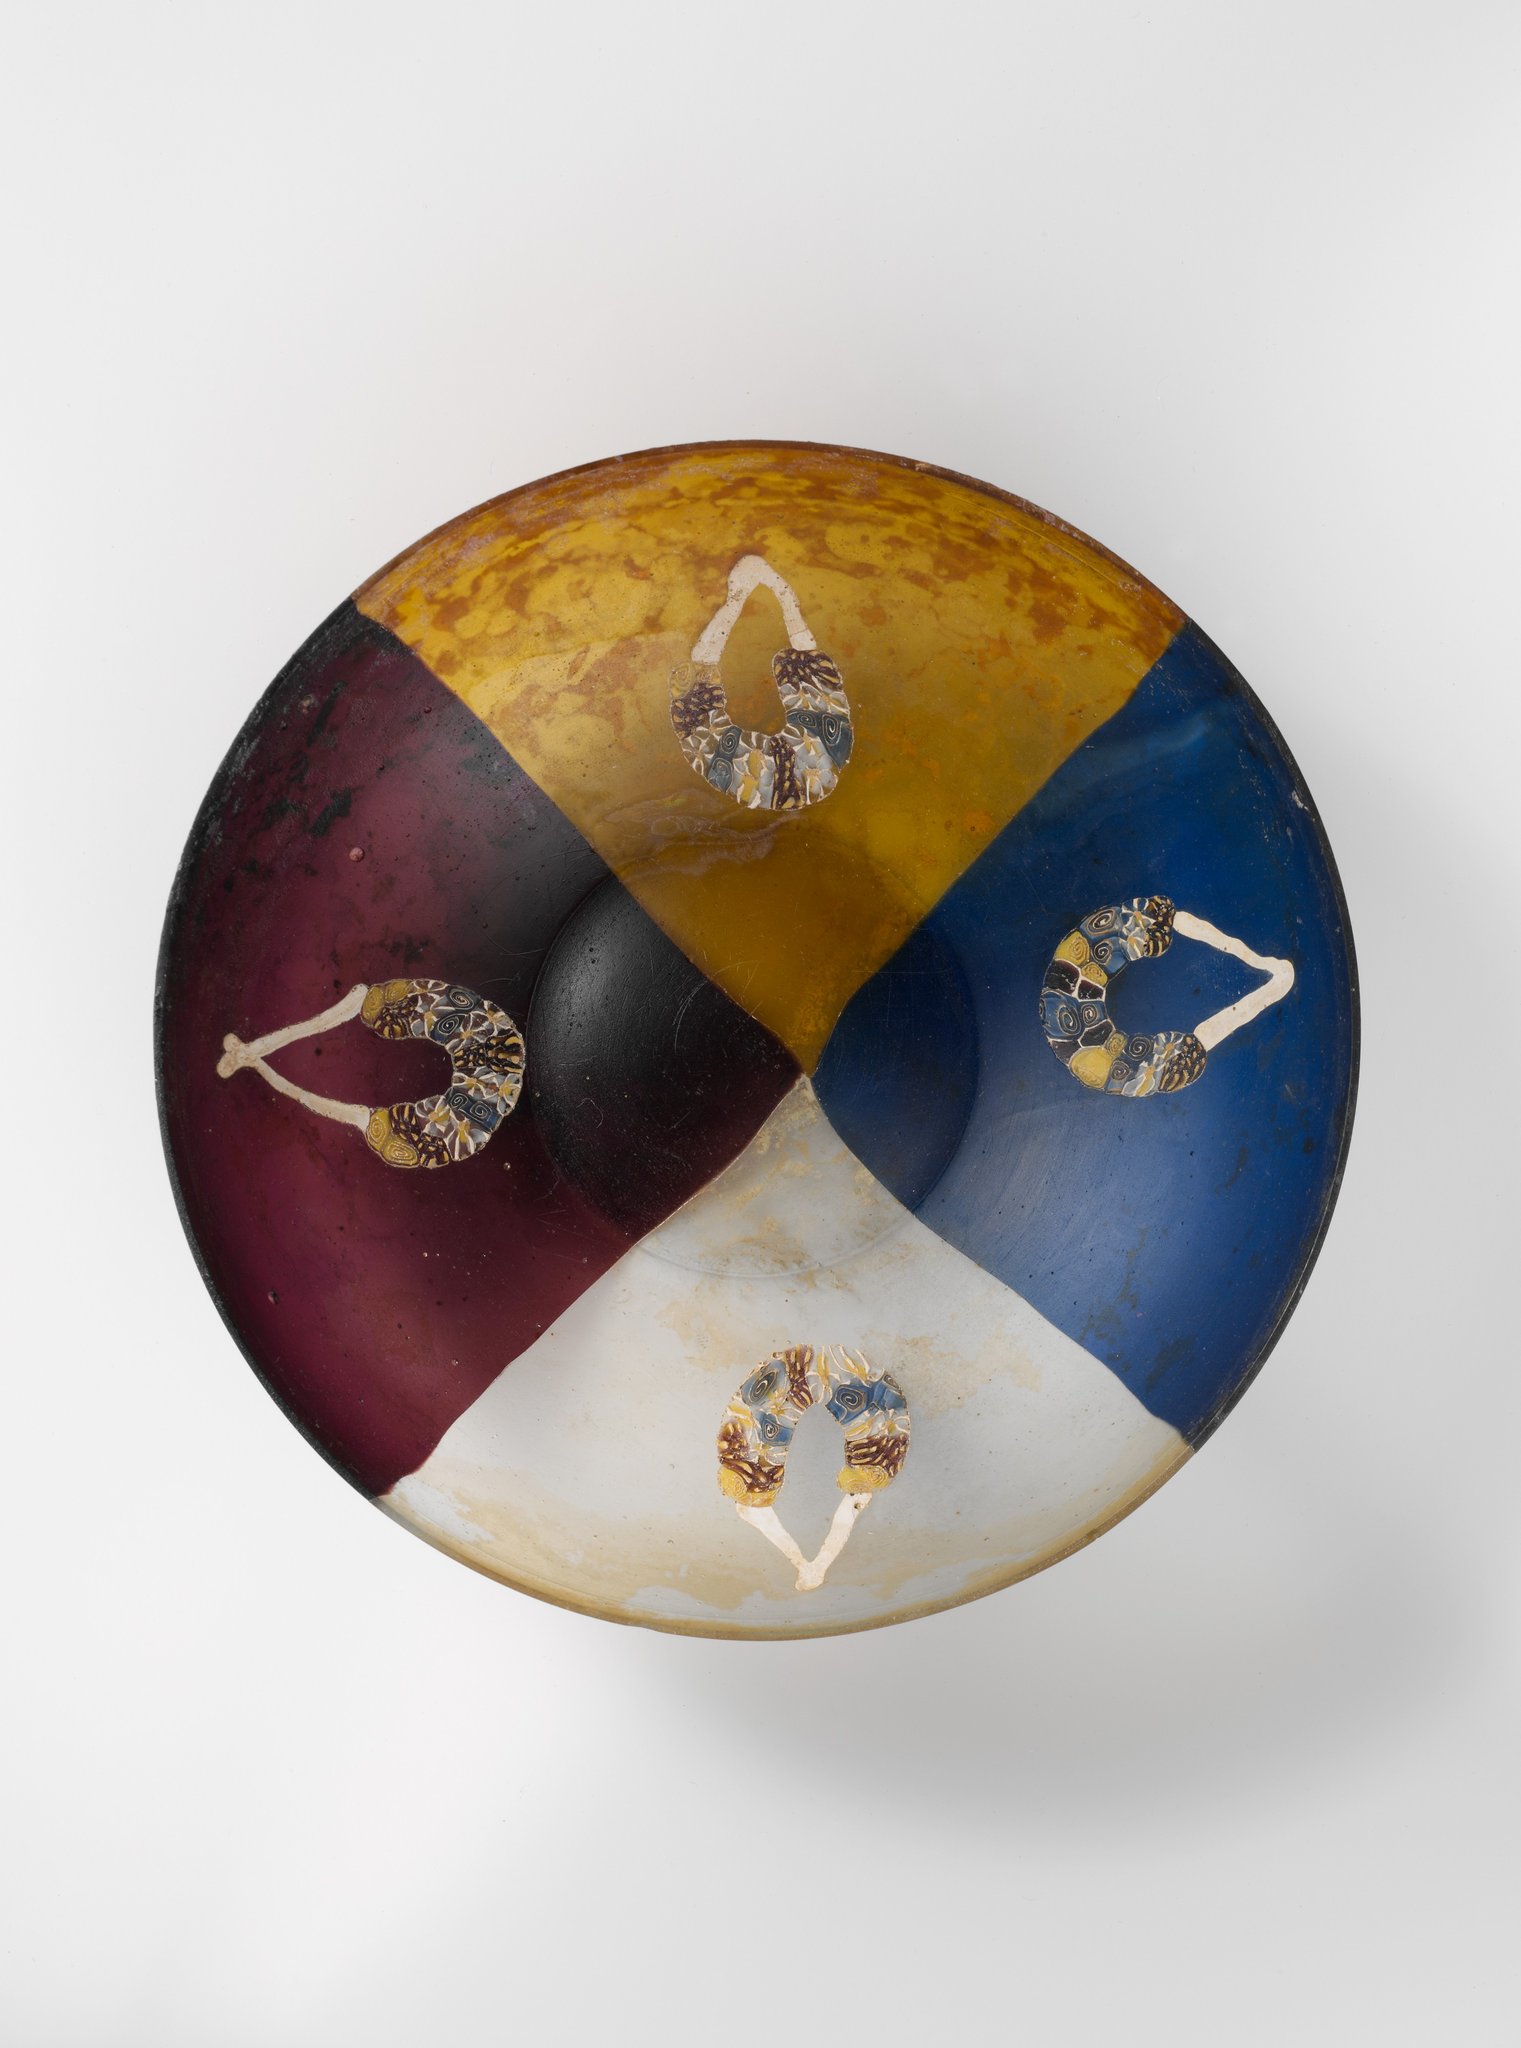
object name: bowl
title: Glass garland bowl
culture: roman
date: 34-1 BCE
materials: glass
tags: garlands